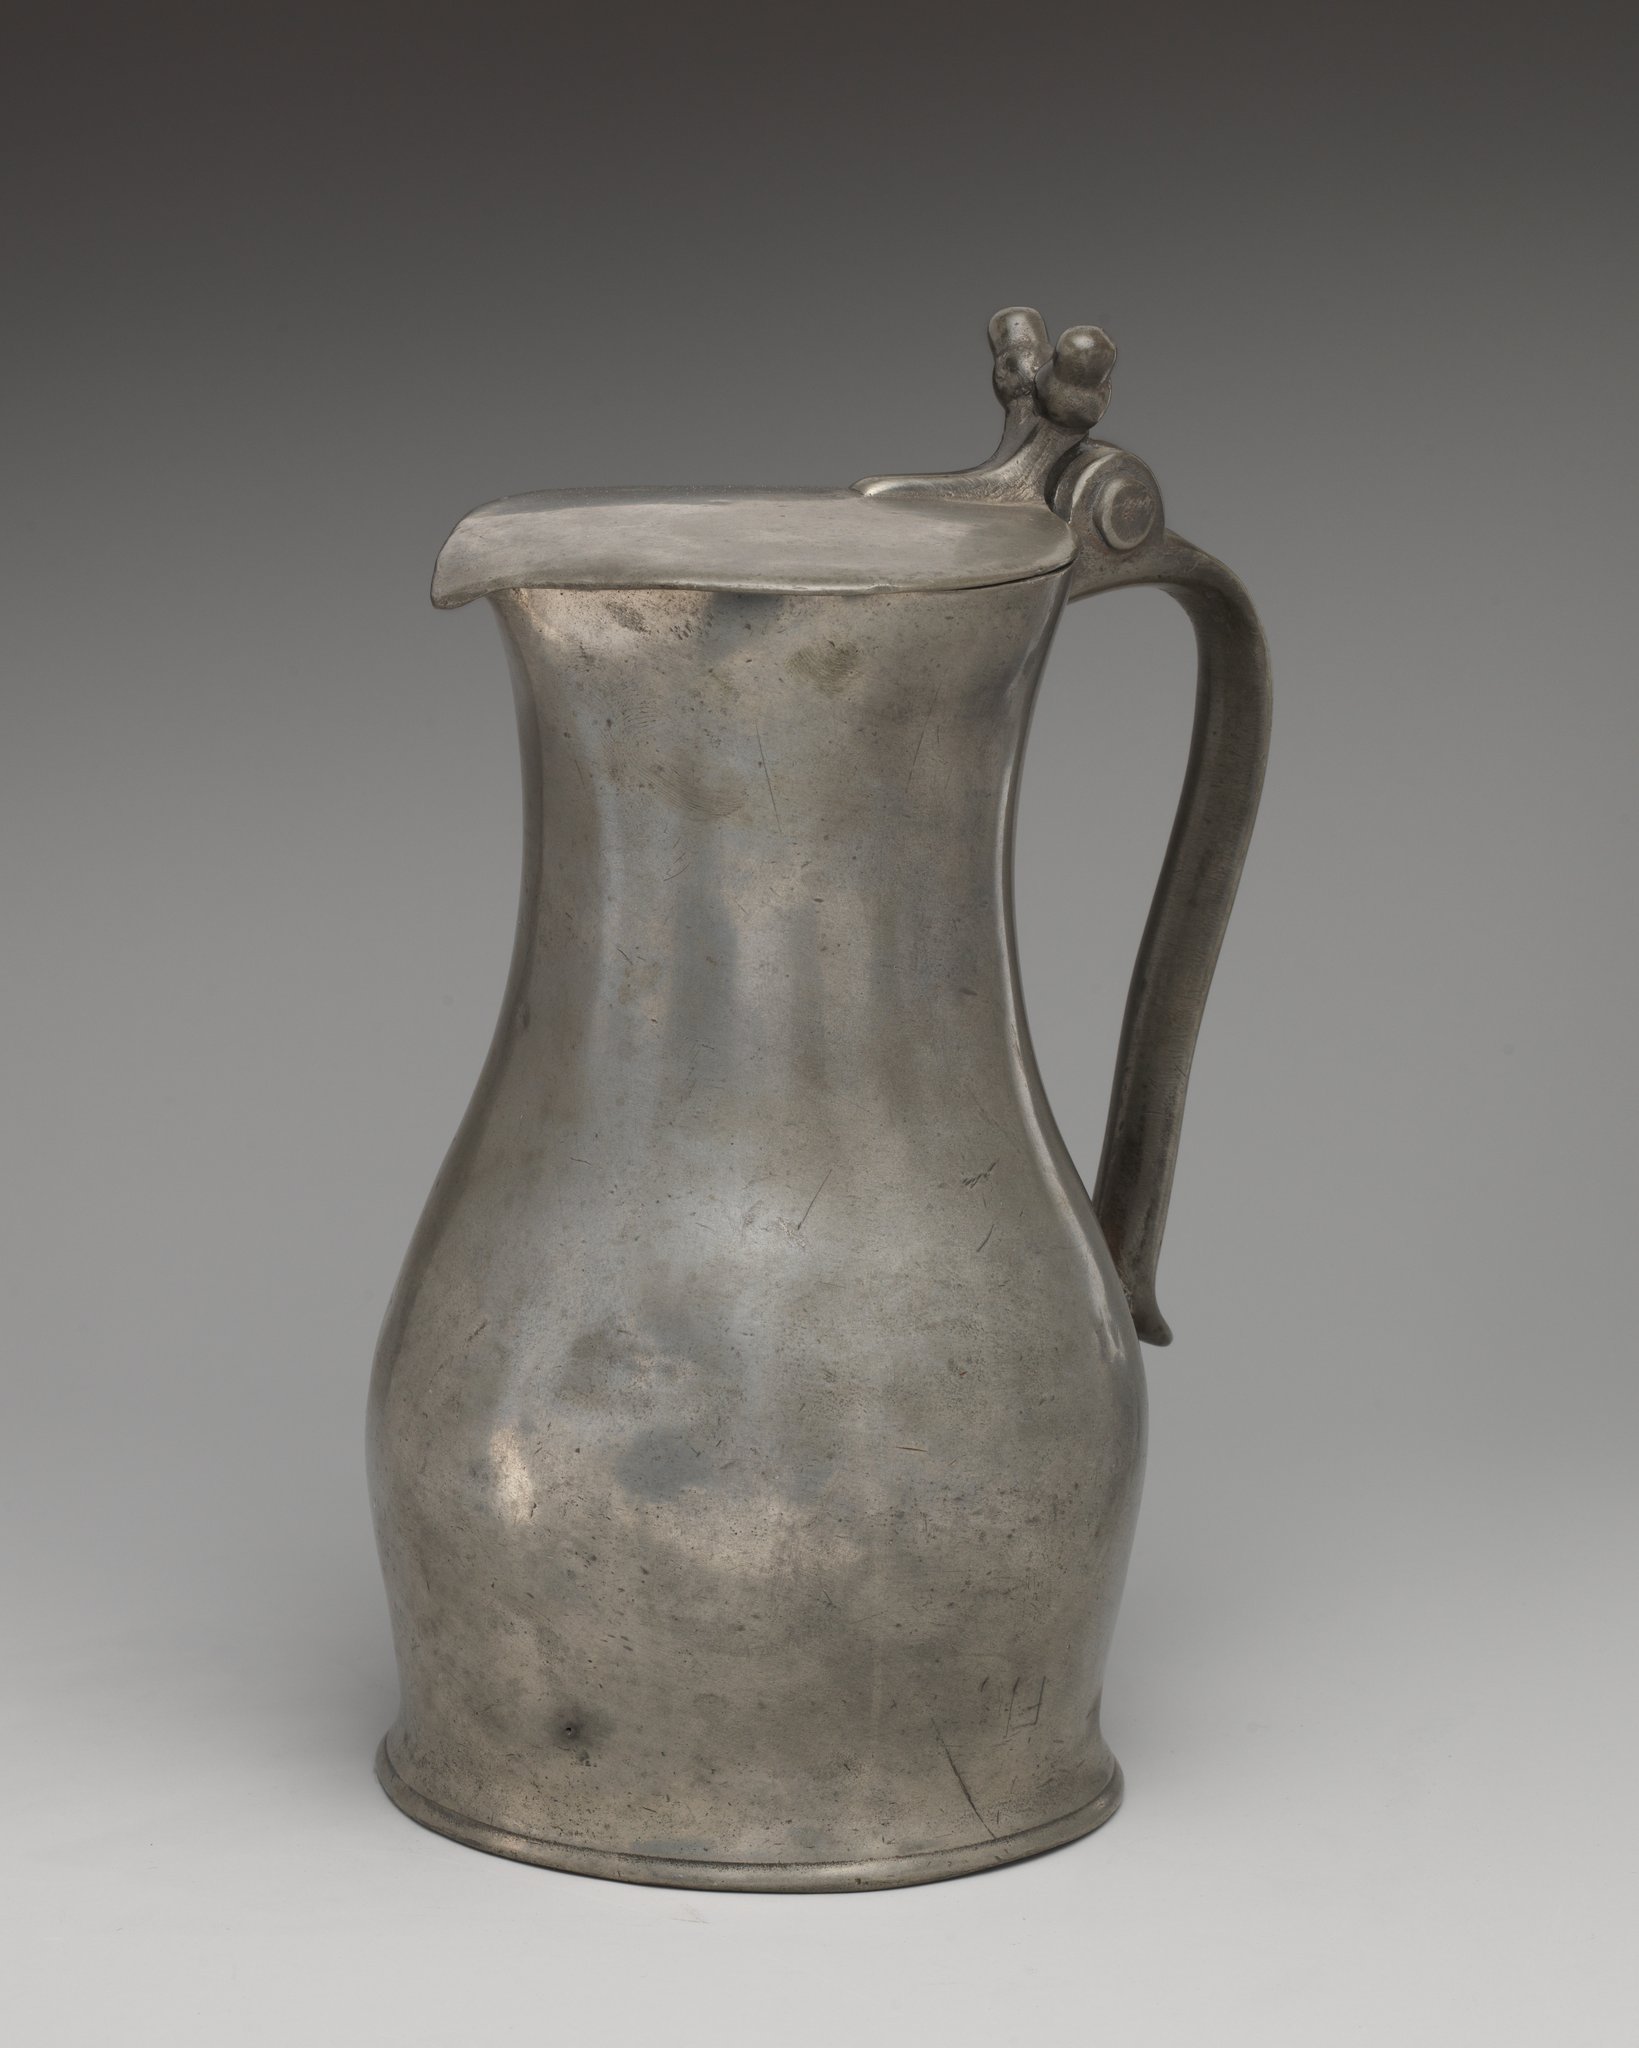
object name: measure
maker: john de st. croix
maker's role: maker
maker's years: 1729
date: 1726-1750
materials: pewter